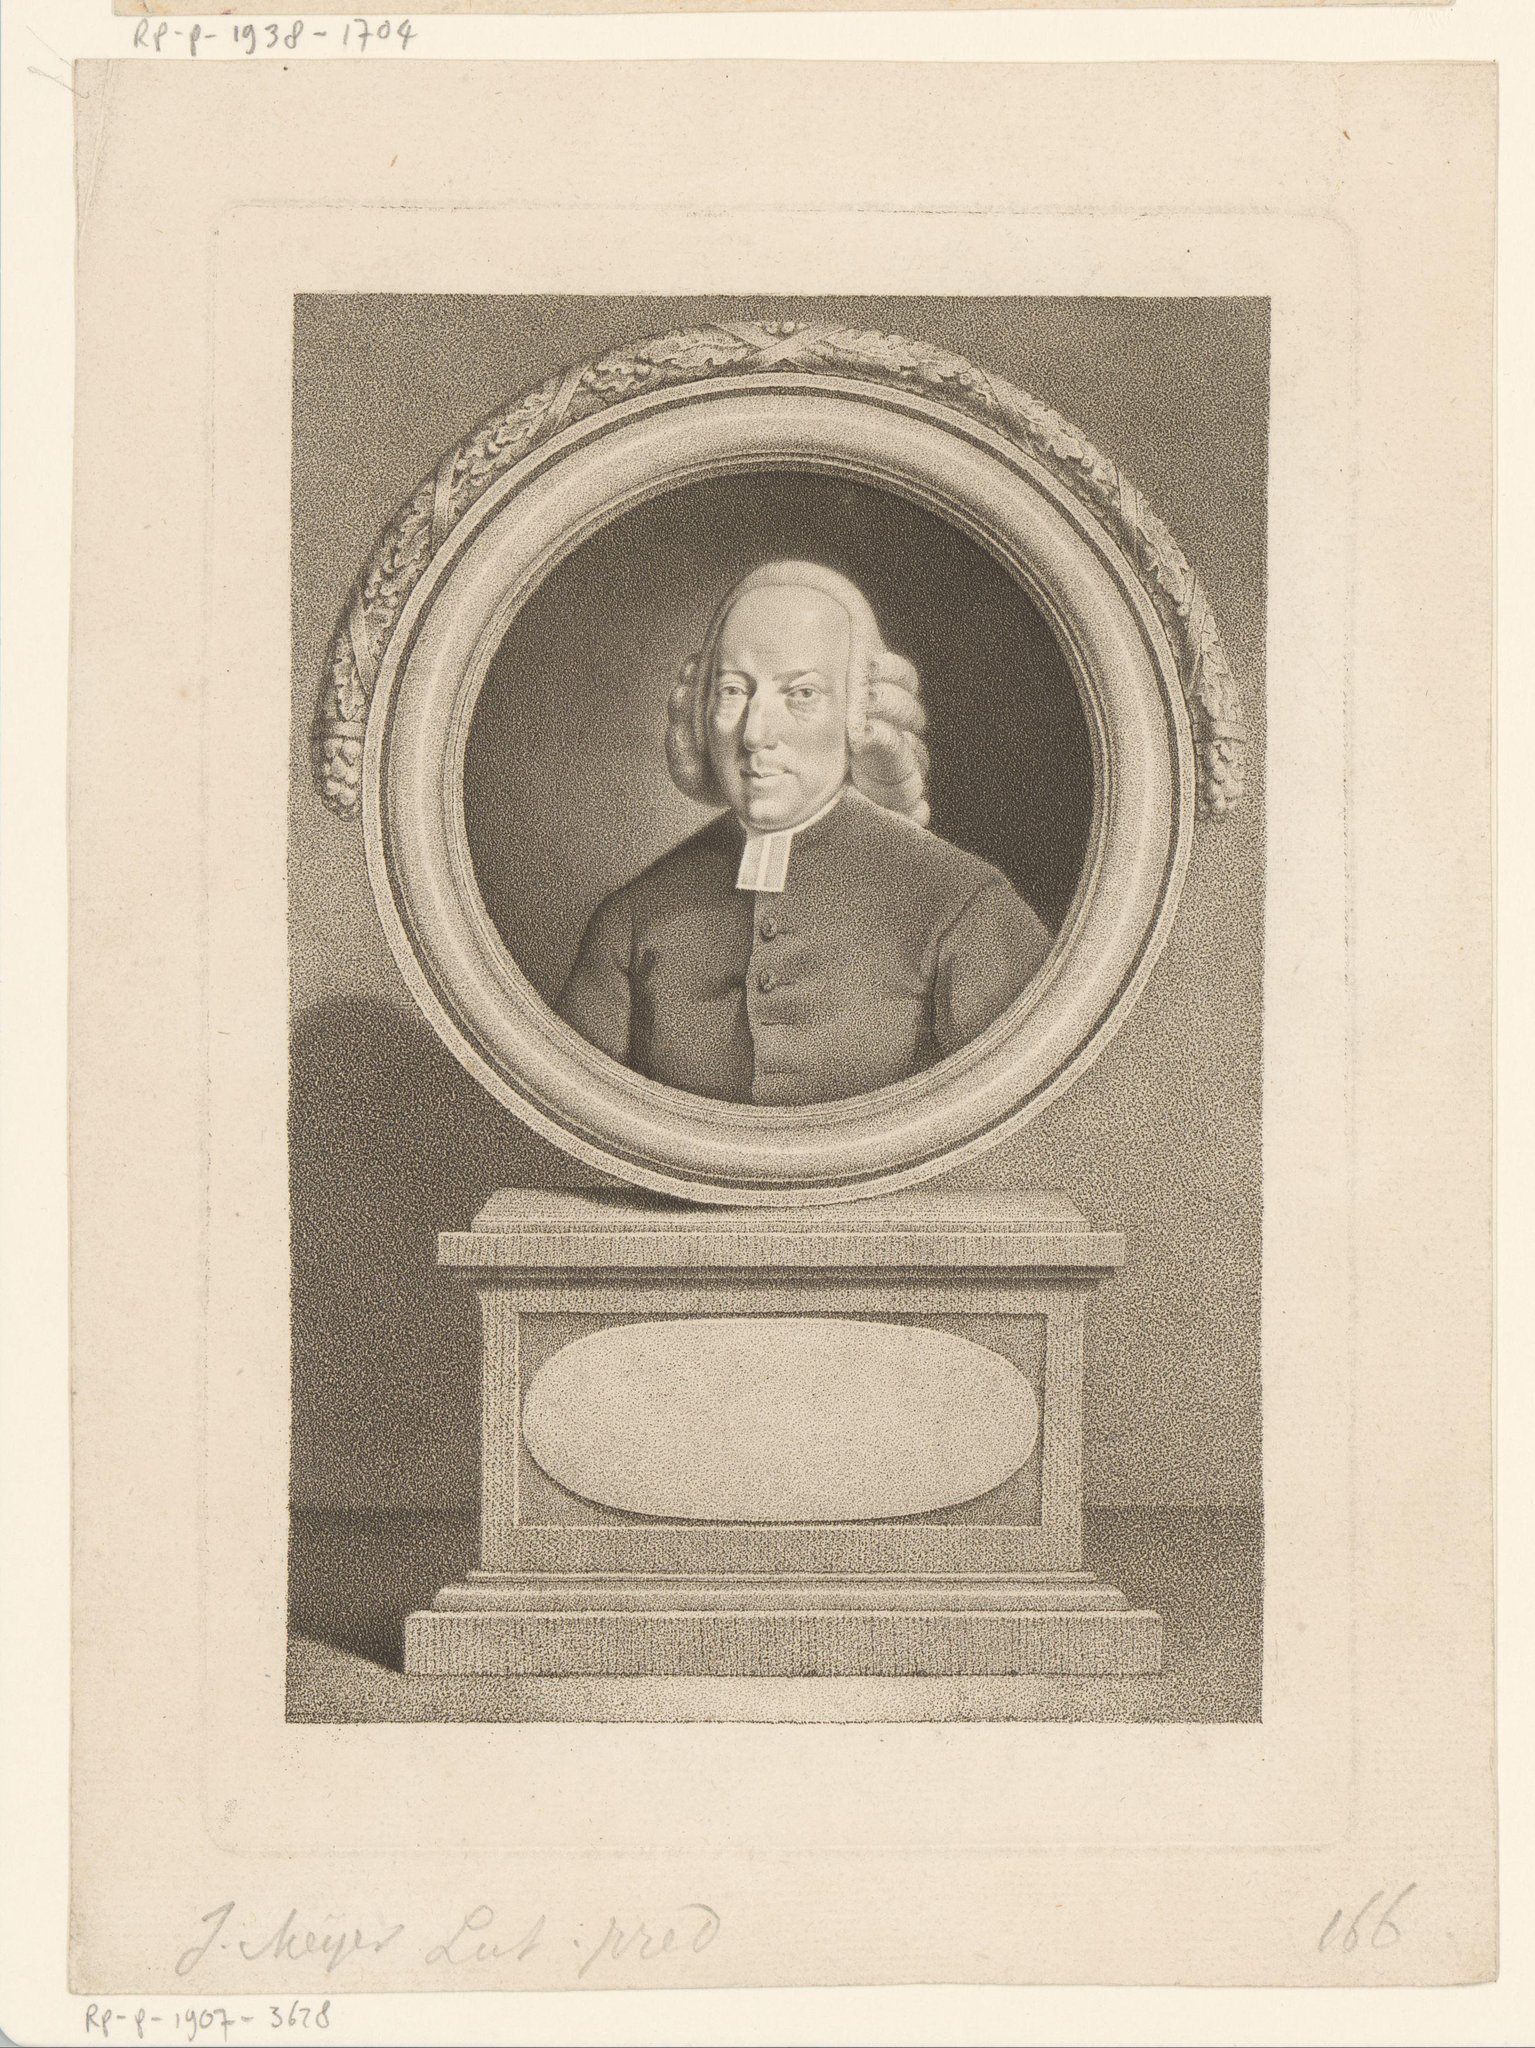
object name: print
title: Portret van Johannes Meijer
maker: johann gottfried pflugfelder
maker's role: print maker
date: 1792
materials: paper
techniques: stippled etching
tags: amsterdam, historical persons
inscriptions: collector's mark: Lugt 2228, number: ‘166’, name